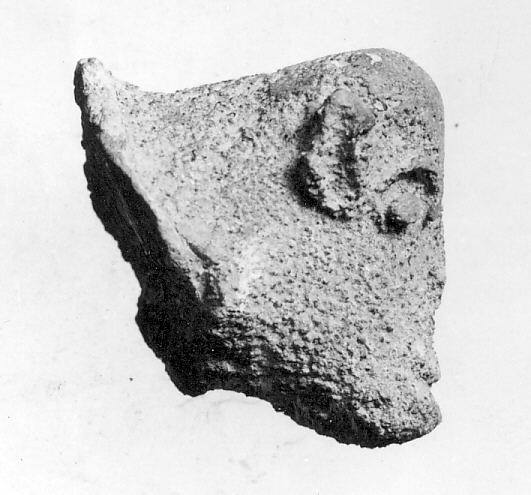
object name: figurine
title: Head of Sheep(?)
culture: central asian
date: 1101-1133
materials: terracotta